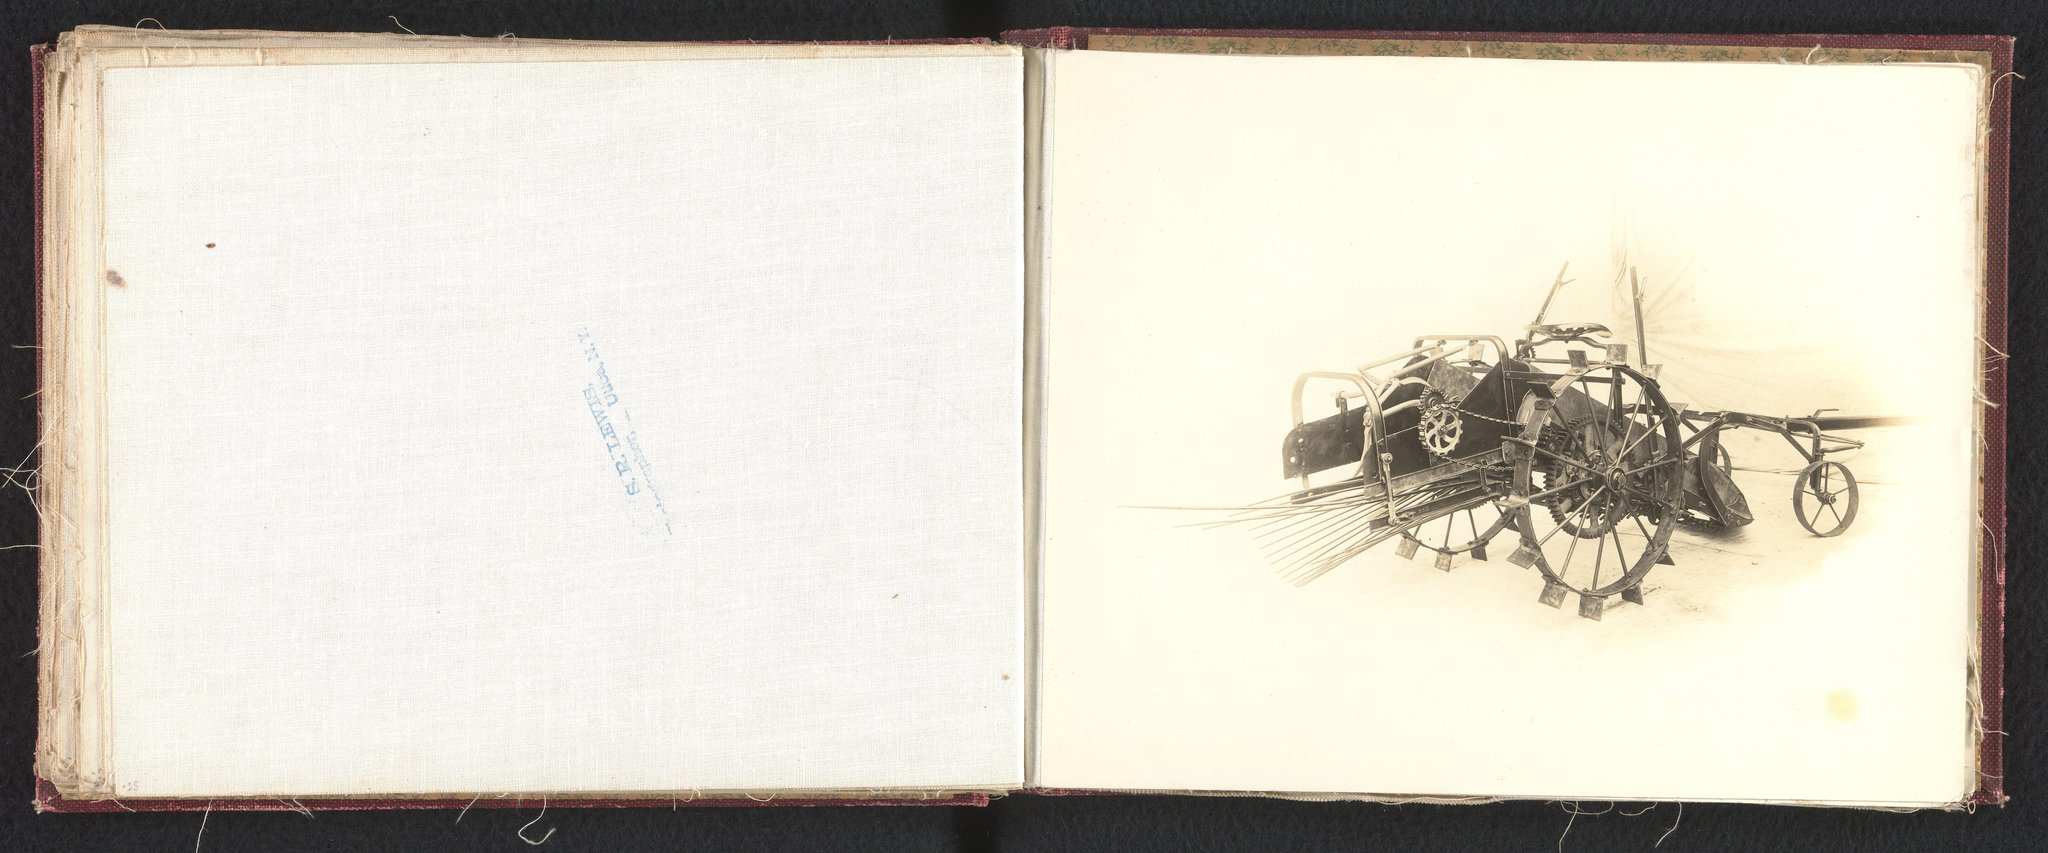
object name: page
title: Landbouwwerktuig van de Eureka Mower Co. te Utrica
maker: lewis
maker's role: fotograaf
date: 1915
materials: paper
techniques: gelatin silver print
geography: utica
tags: agricultural implements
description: Foto op 23e ongenummerde pagina na voorplat.